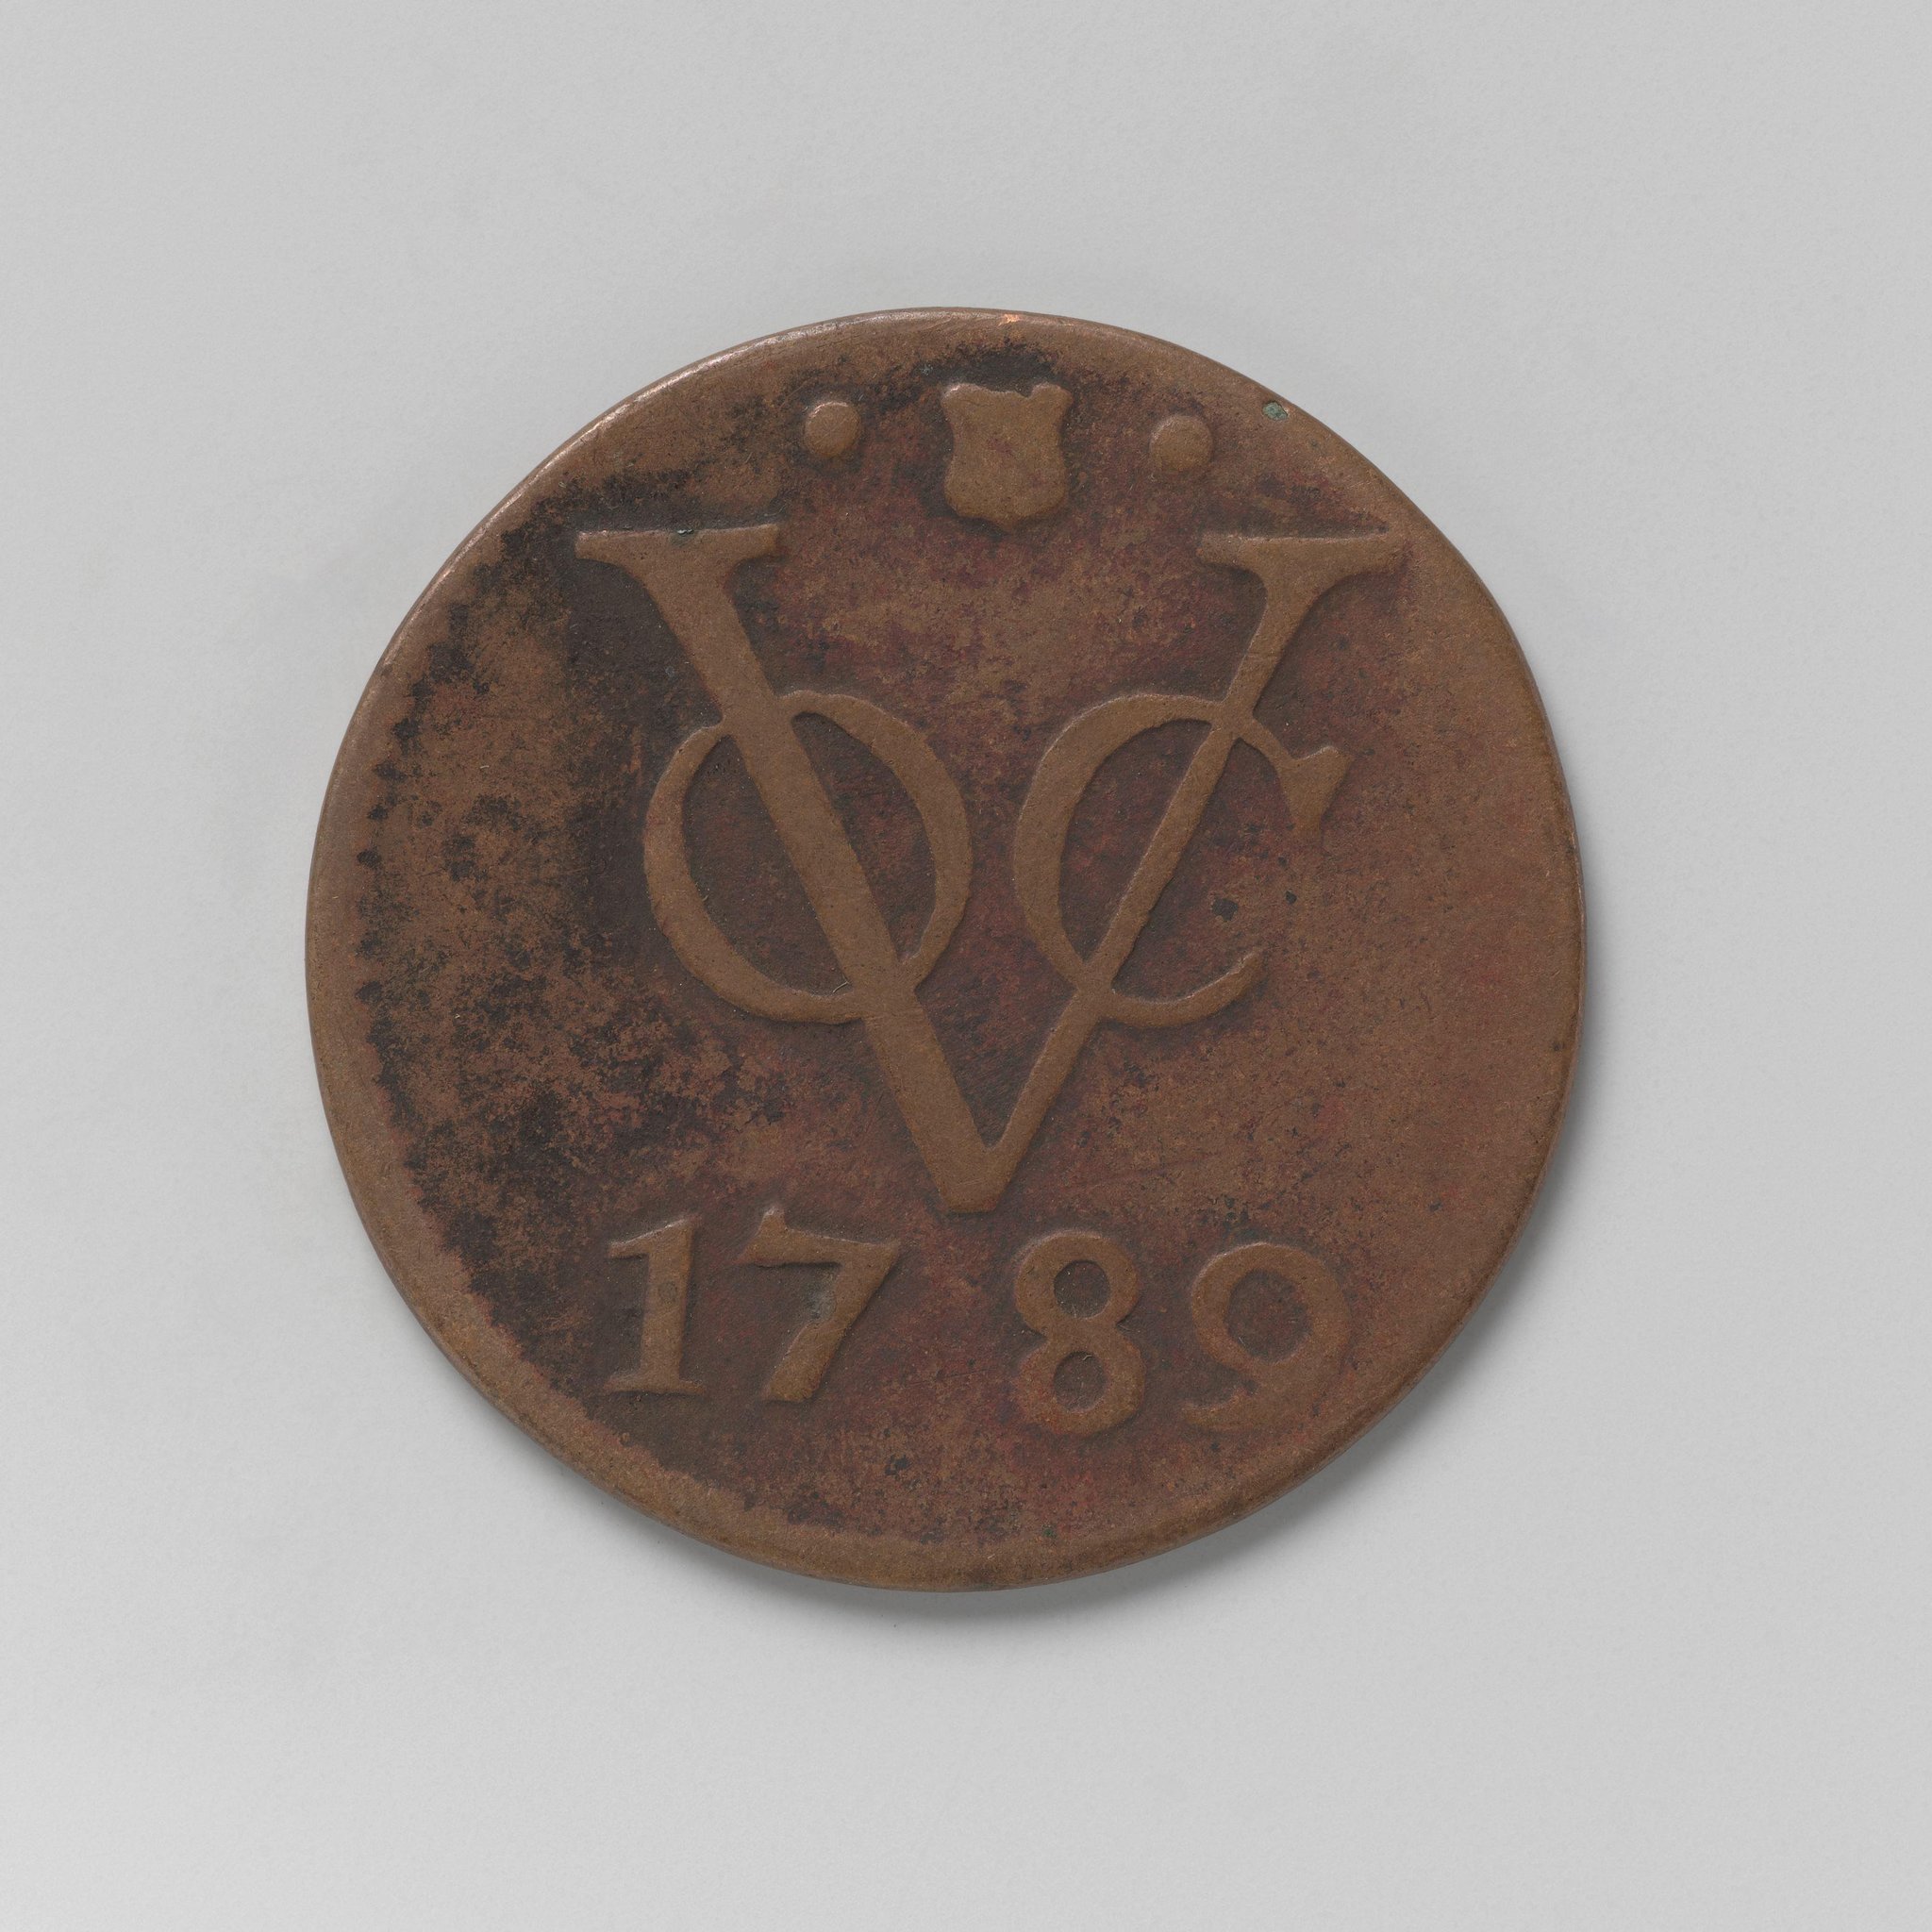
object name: coin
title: VOC, duit, stad Utrecht,1789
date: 1789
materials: copper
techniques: striking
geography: utrecht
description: Koperen munt. Voorzijde: op balk, waaronder guirlande, staand, door twee leeuwen gehouden gekroond wapenschild van de stad Utrecht. Keerzijde: monogram van de VOC, waarboven muntteken en waaronder jaartal. Gladde rand.